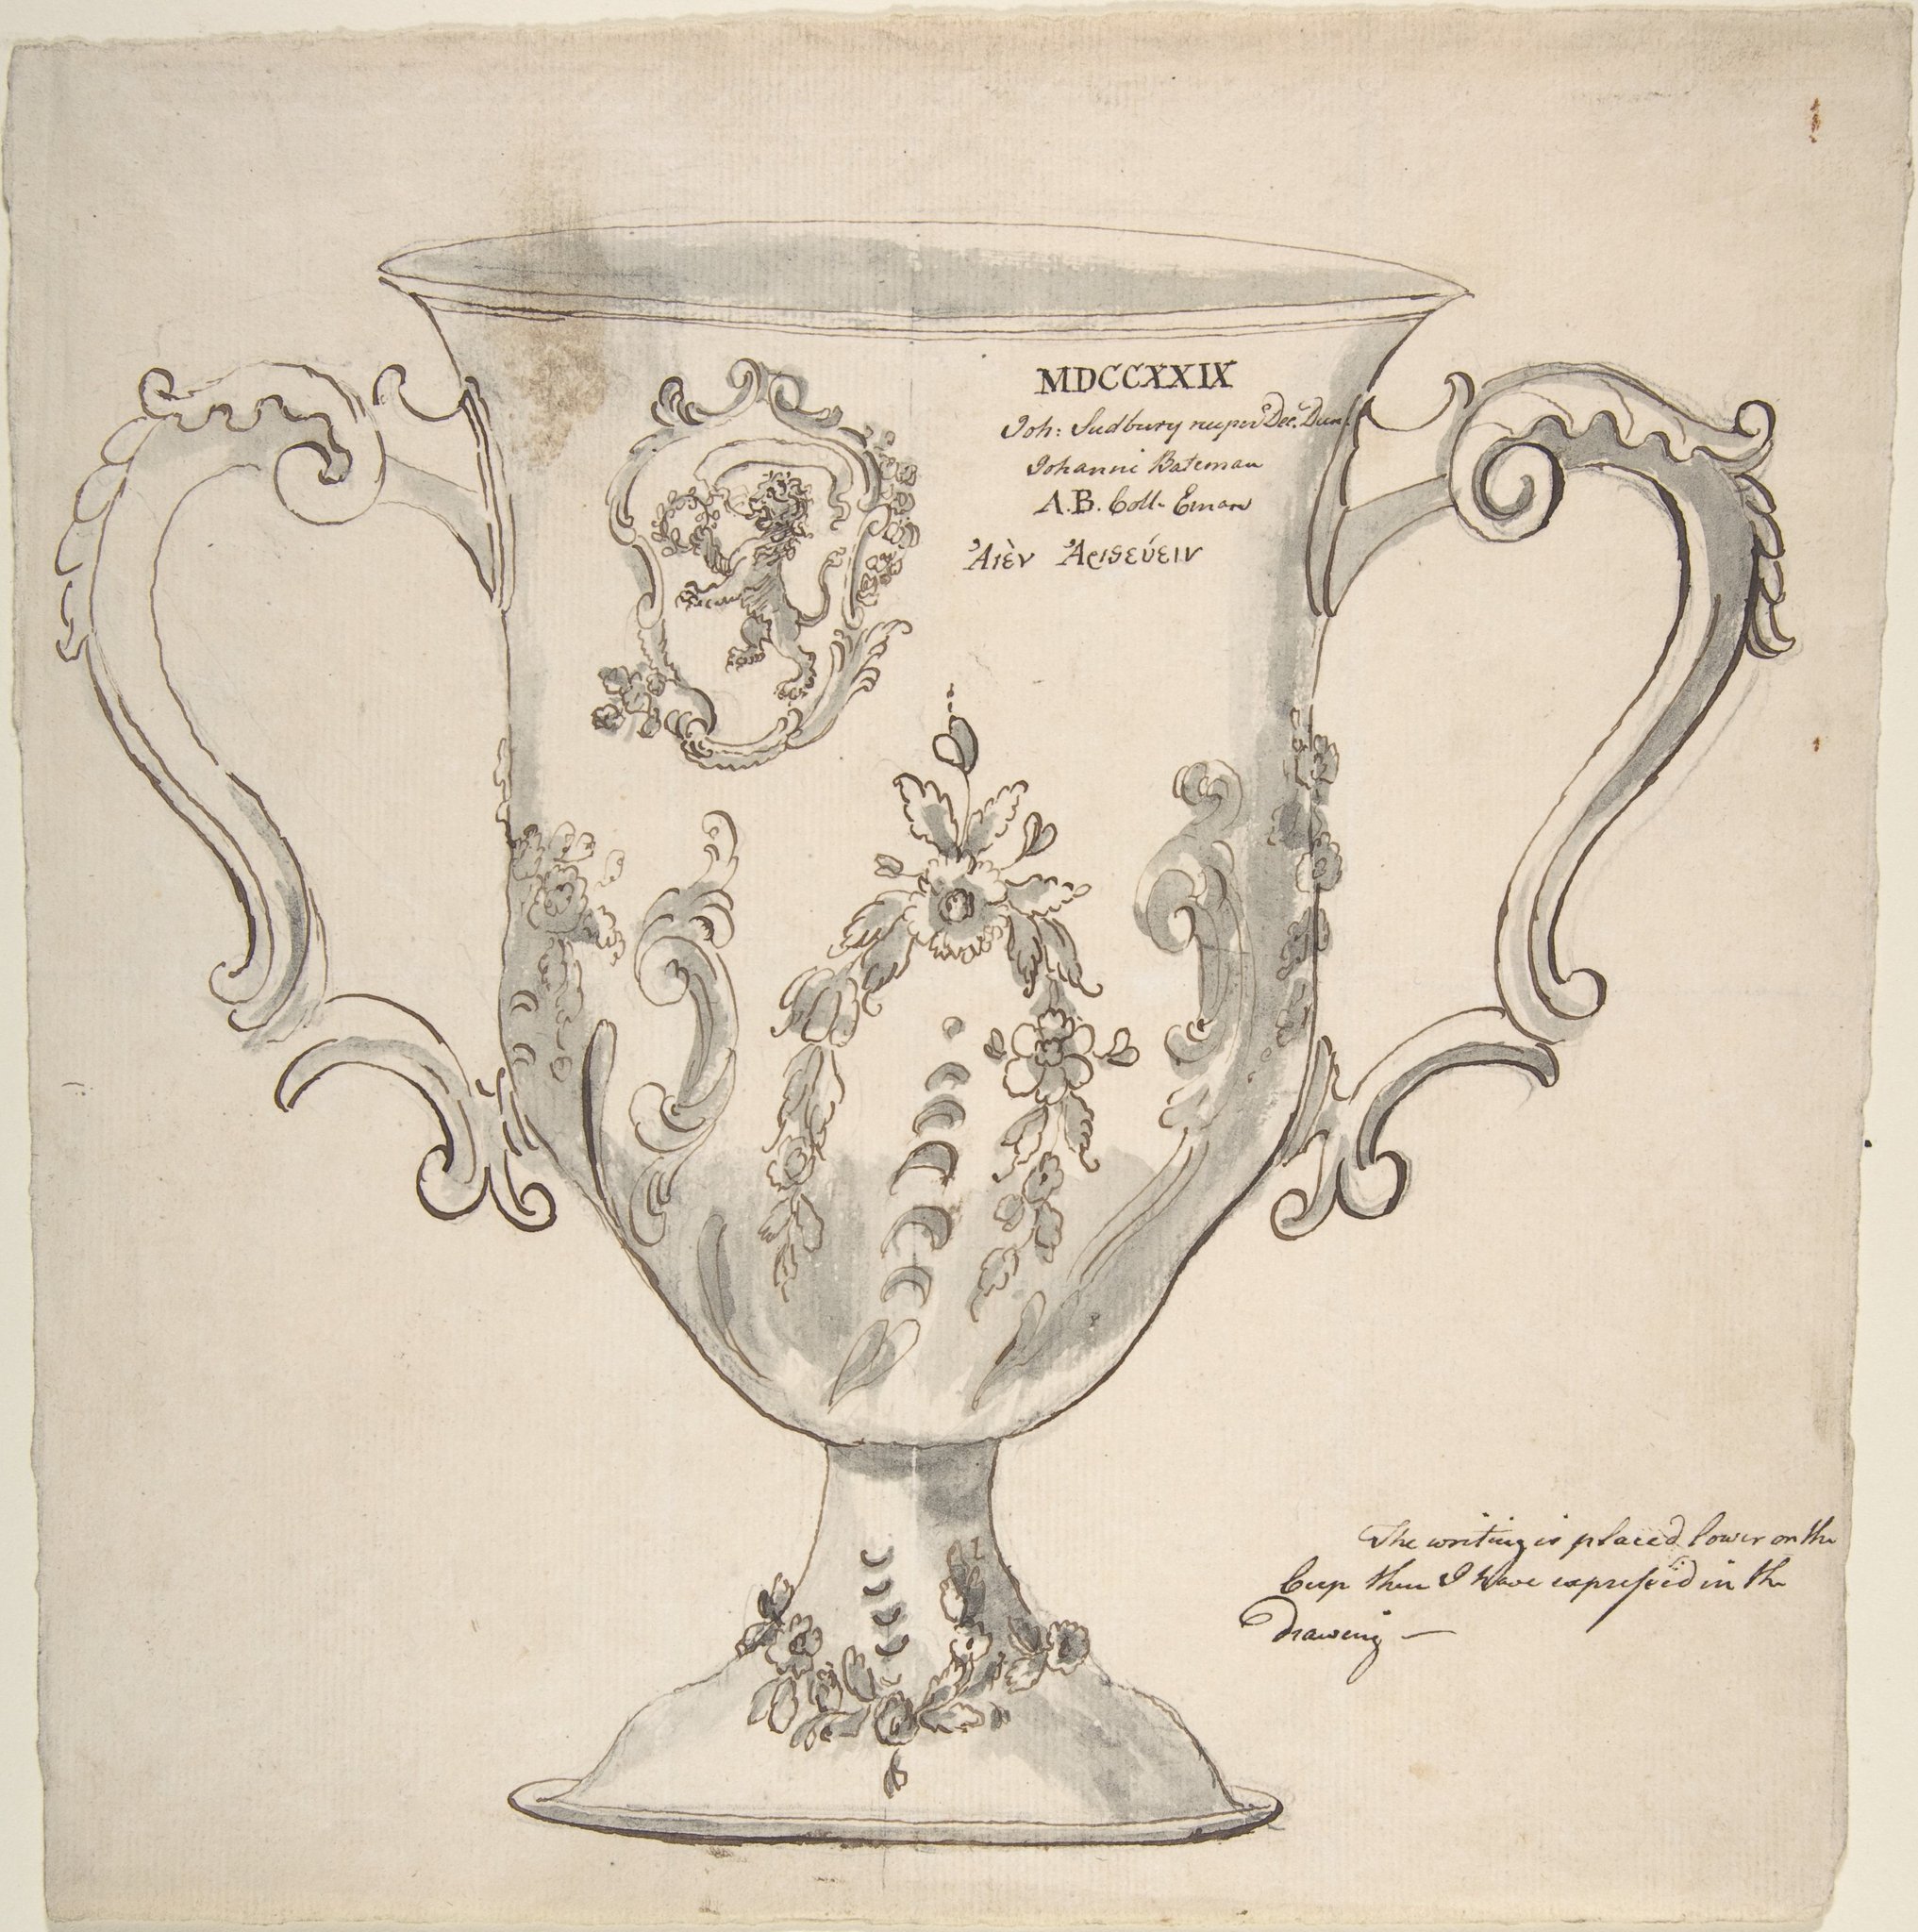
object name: drawing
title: A Silver Urn, inscribed "MDCCXXIX...John Sudbury...Johanni Bateman"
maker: anonymous, british, 19th century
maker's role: artist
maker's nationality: british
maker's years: 1800-1900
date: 1828-1840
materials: ink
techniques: brush, pen, wash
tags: cartouches,lions,flowers,urns